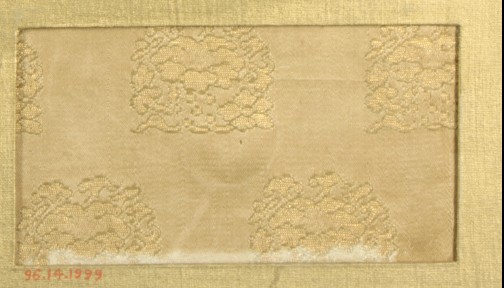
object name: piece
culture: japanese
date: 1701-1900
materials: silk